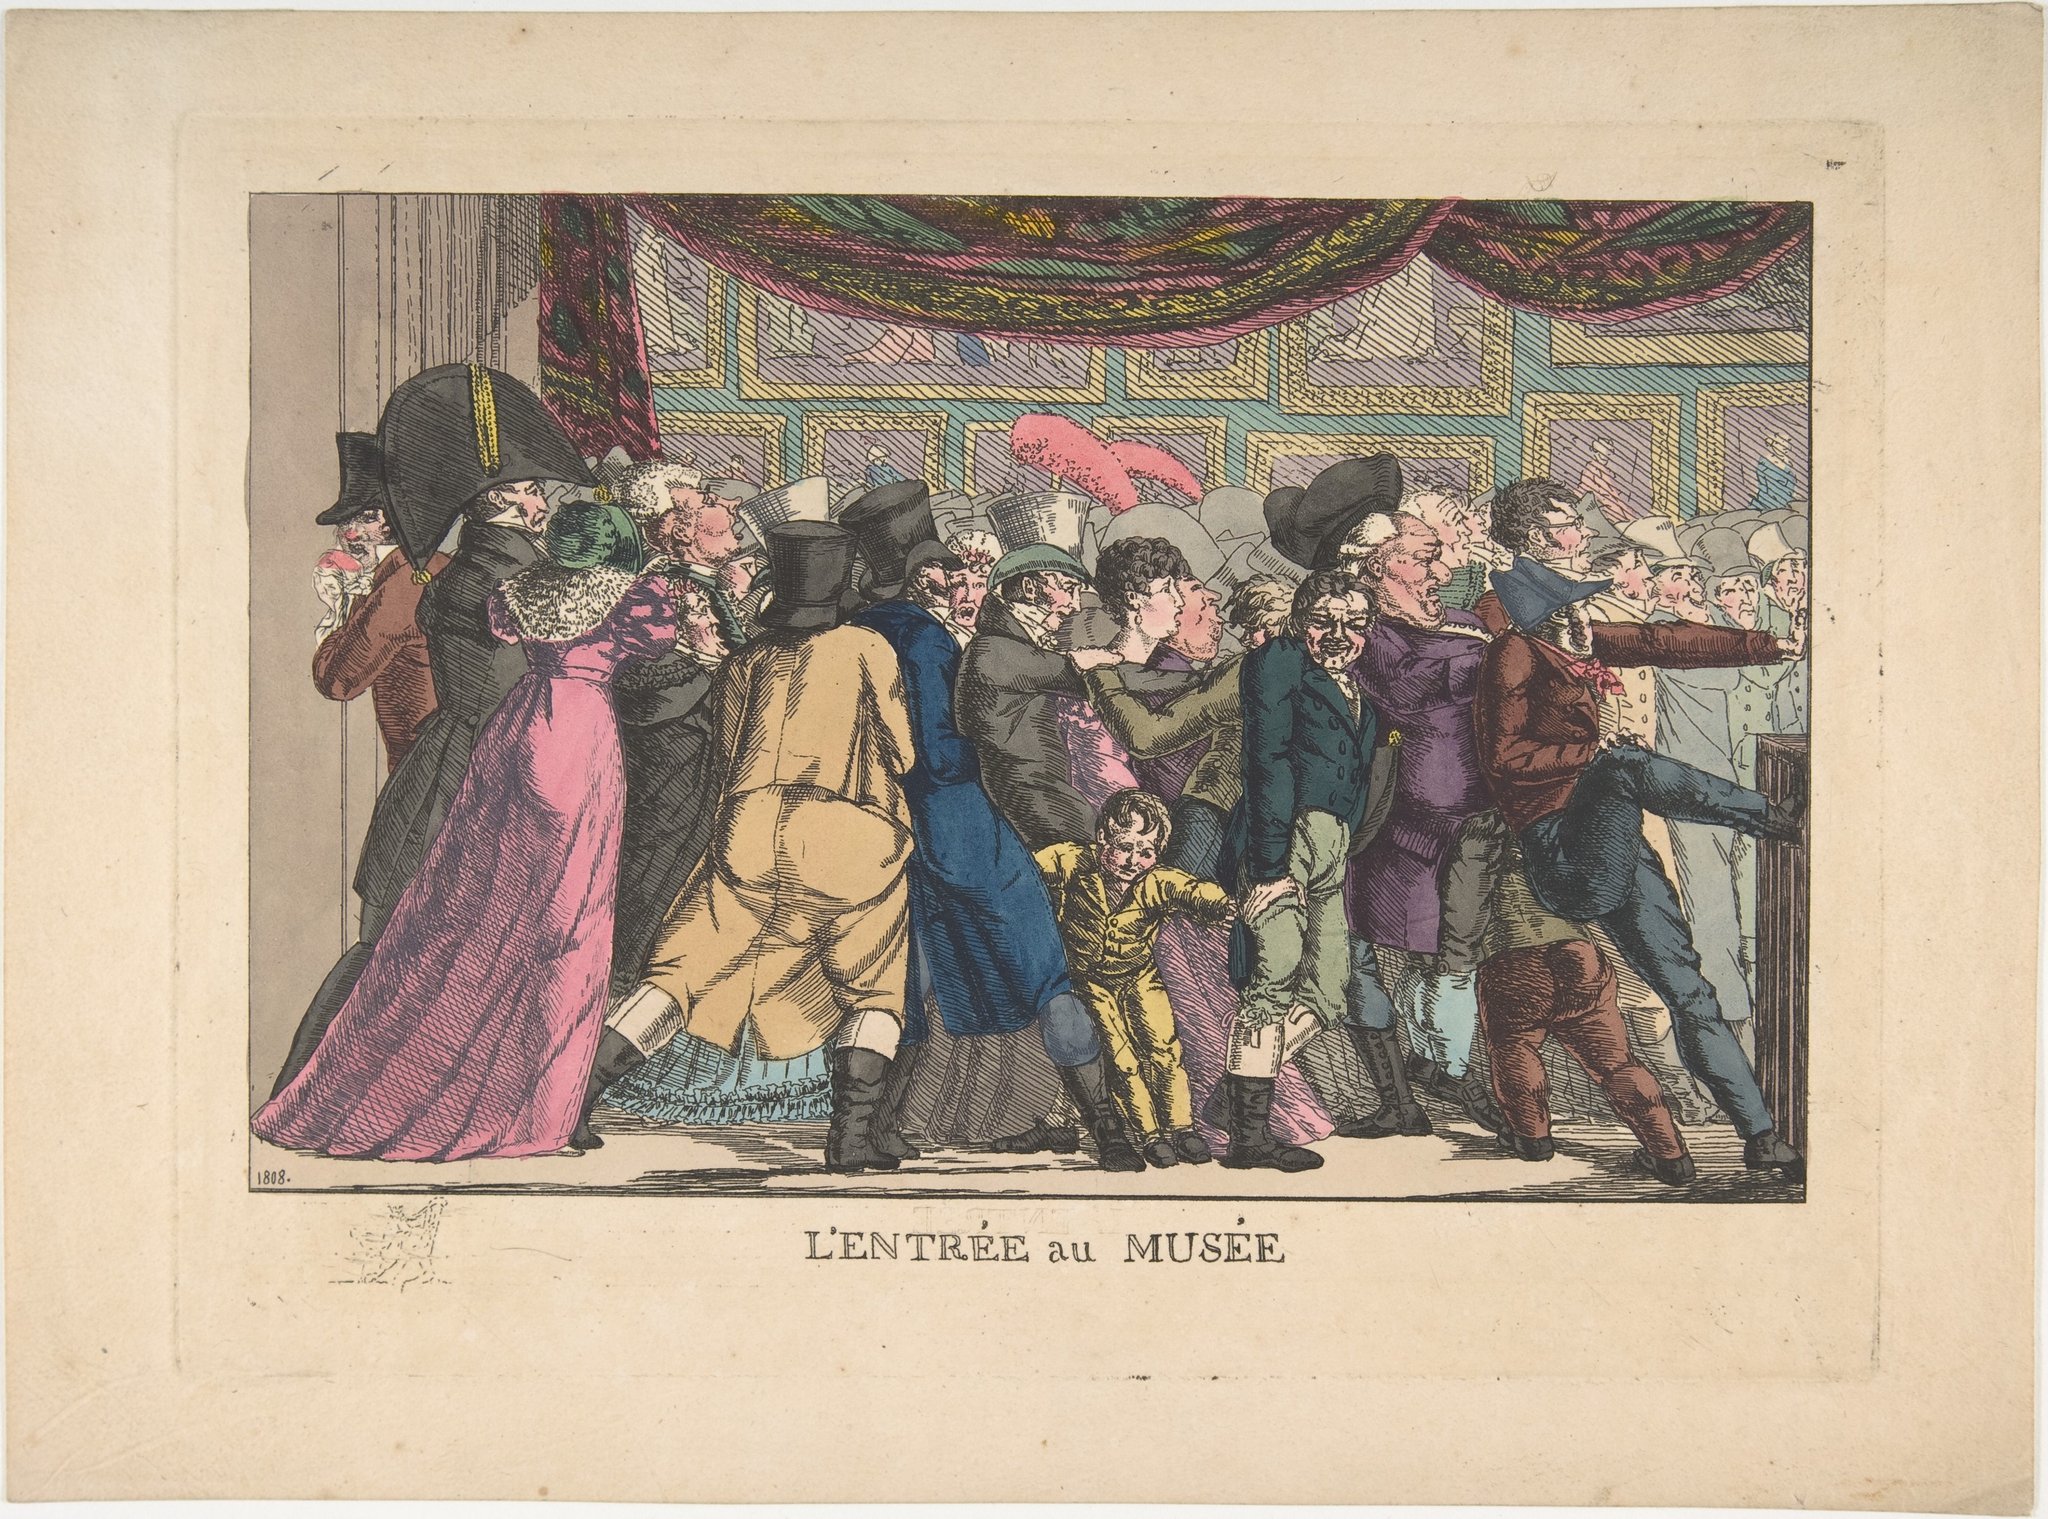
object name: print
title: L'Entrée au Musée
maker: anonymous, french, 19th century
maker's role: artist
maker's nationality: french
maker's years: 1800-1900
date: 1808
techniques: etching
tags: children,men,women